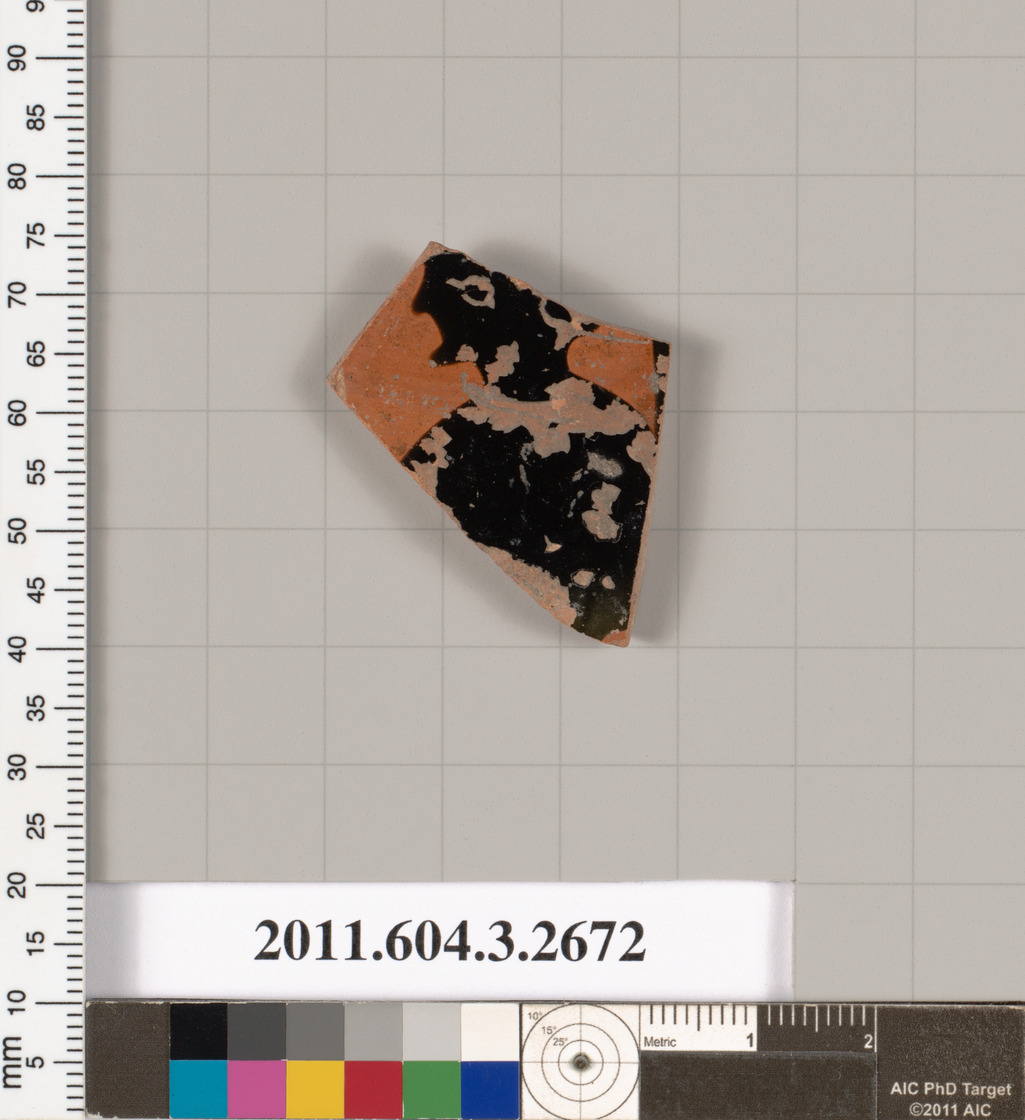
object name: olpe fragment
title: Terracotta fragment of an olpe (jug)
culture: greek, attic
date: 534-468 BCE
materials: terracotta